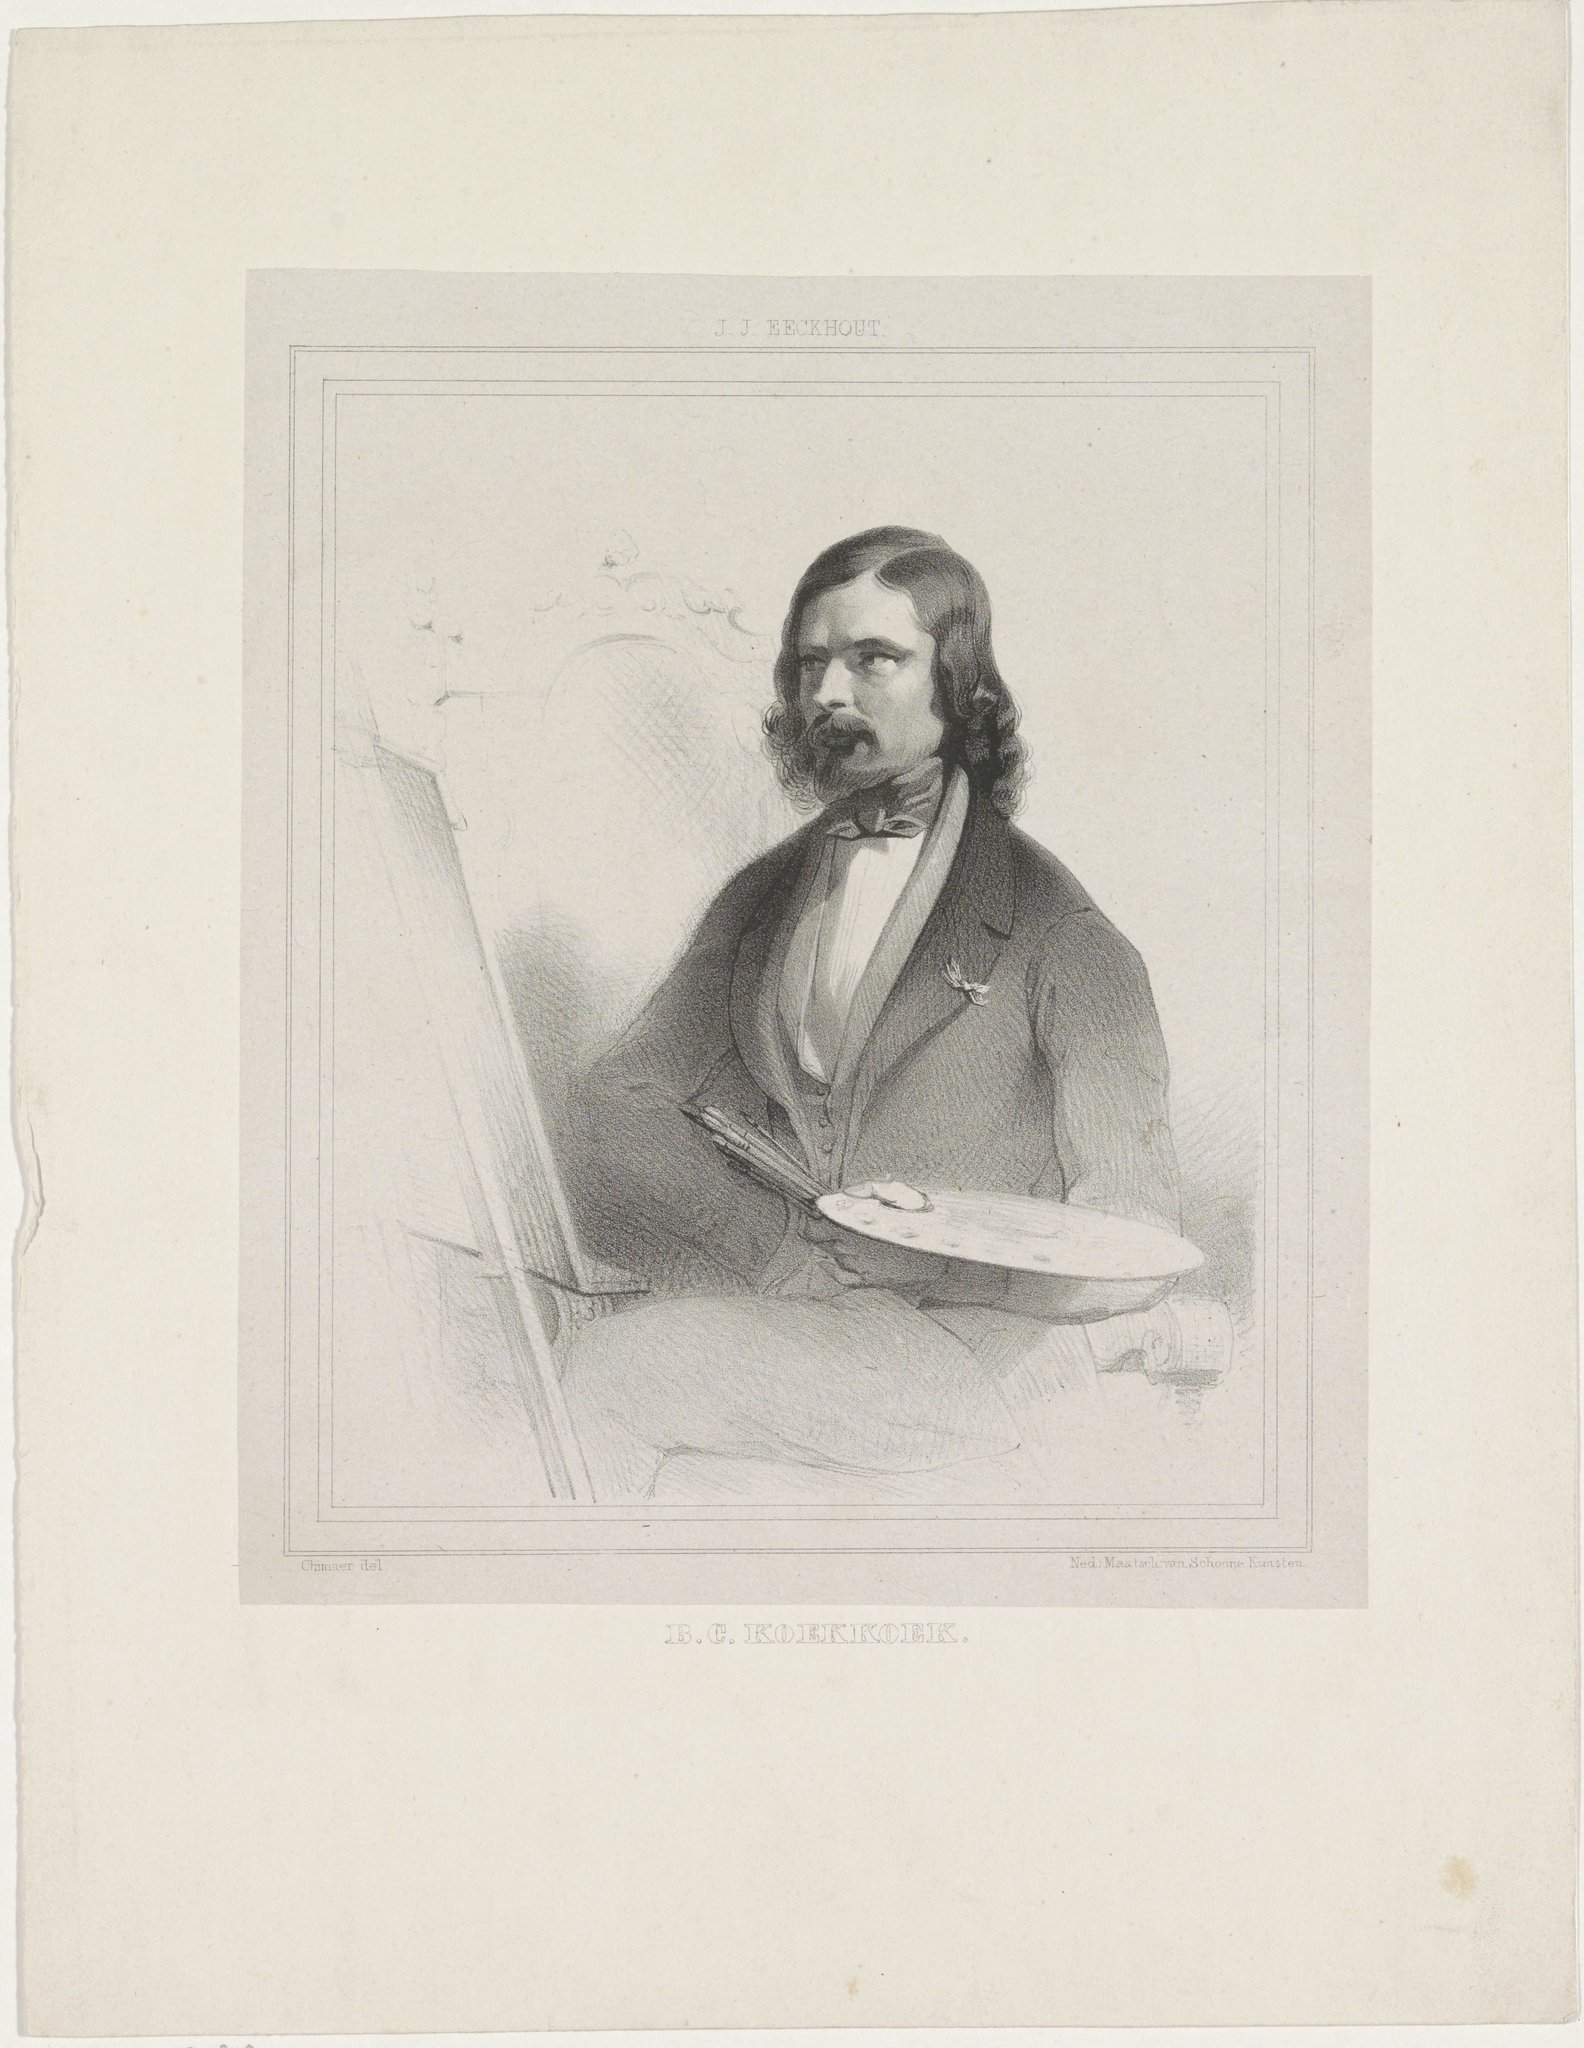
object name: print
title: Portret van Barend Cornelis Koekkoek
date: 1840-1843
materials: paper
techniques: lithograph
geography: netherlands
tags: middelburg, cleves, painter, print maker, draughtsman, barend cornelis koekkoek, easel (+ artist at work), palette (+ artist at work), historical persons (+ three-quarter length portrait)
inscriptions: collector's mark: Lugt 2228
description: De geportretteerde zit voor zijn ezel en kijkt naar het doek. In zijn linkerhand heeft hij een palet en penselen. Achter hem staat een stoel. Hij draagt een ridderorde op de revers van zijn jas. Onder het portret zijn naam.